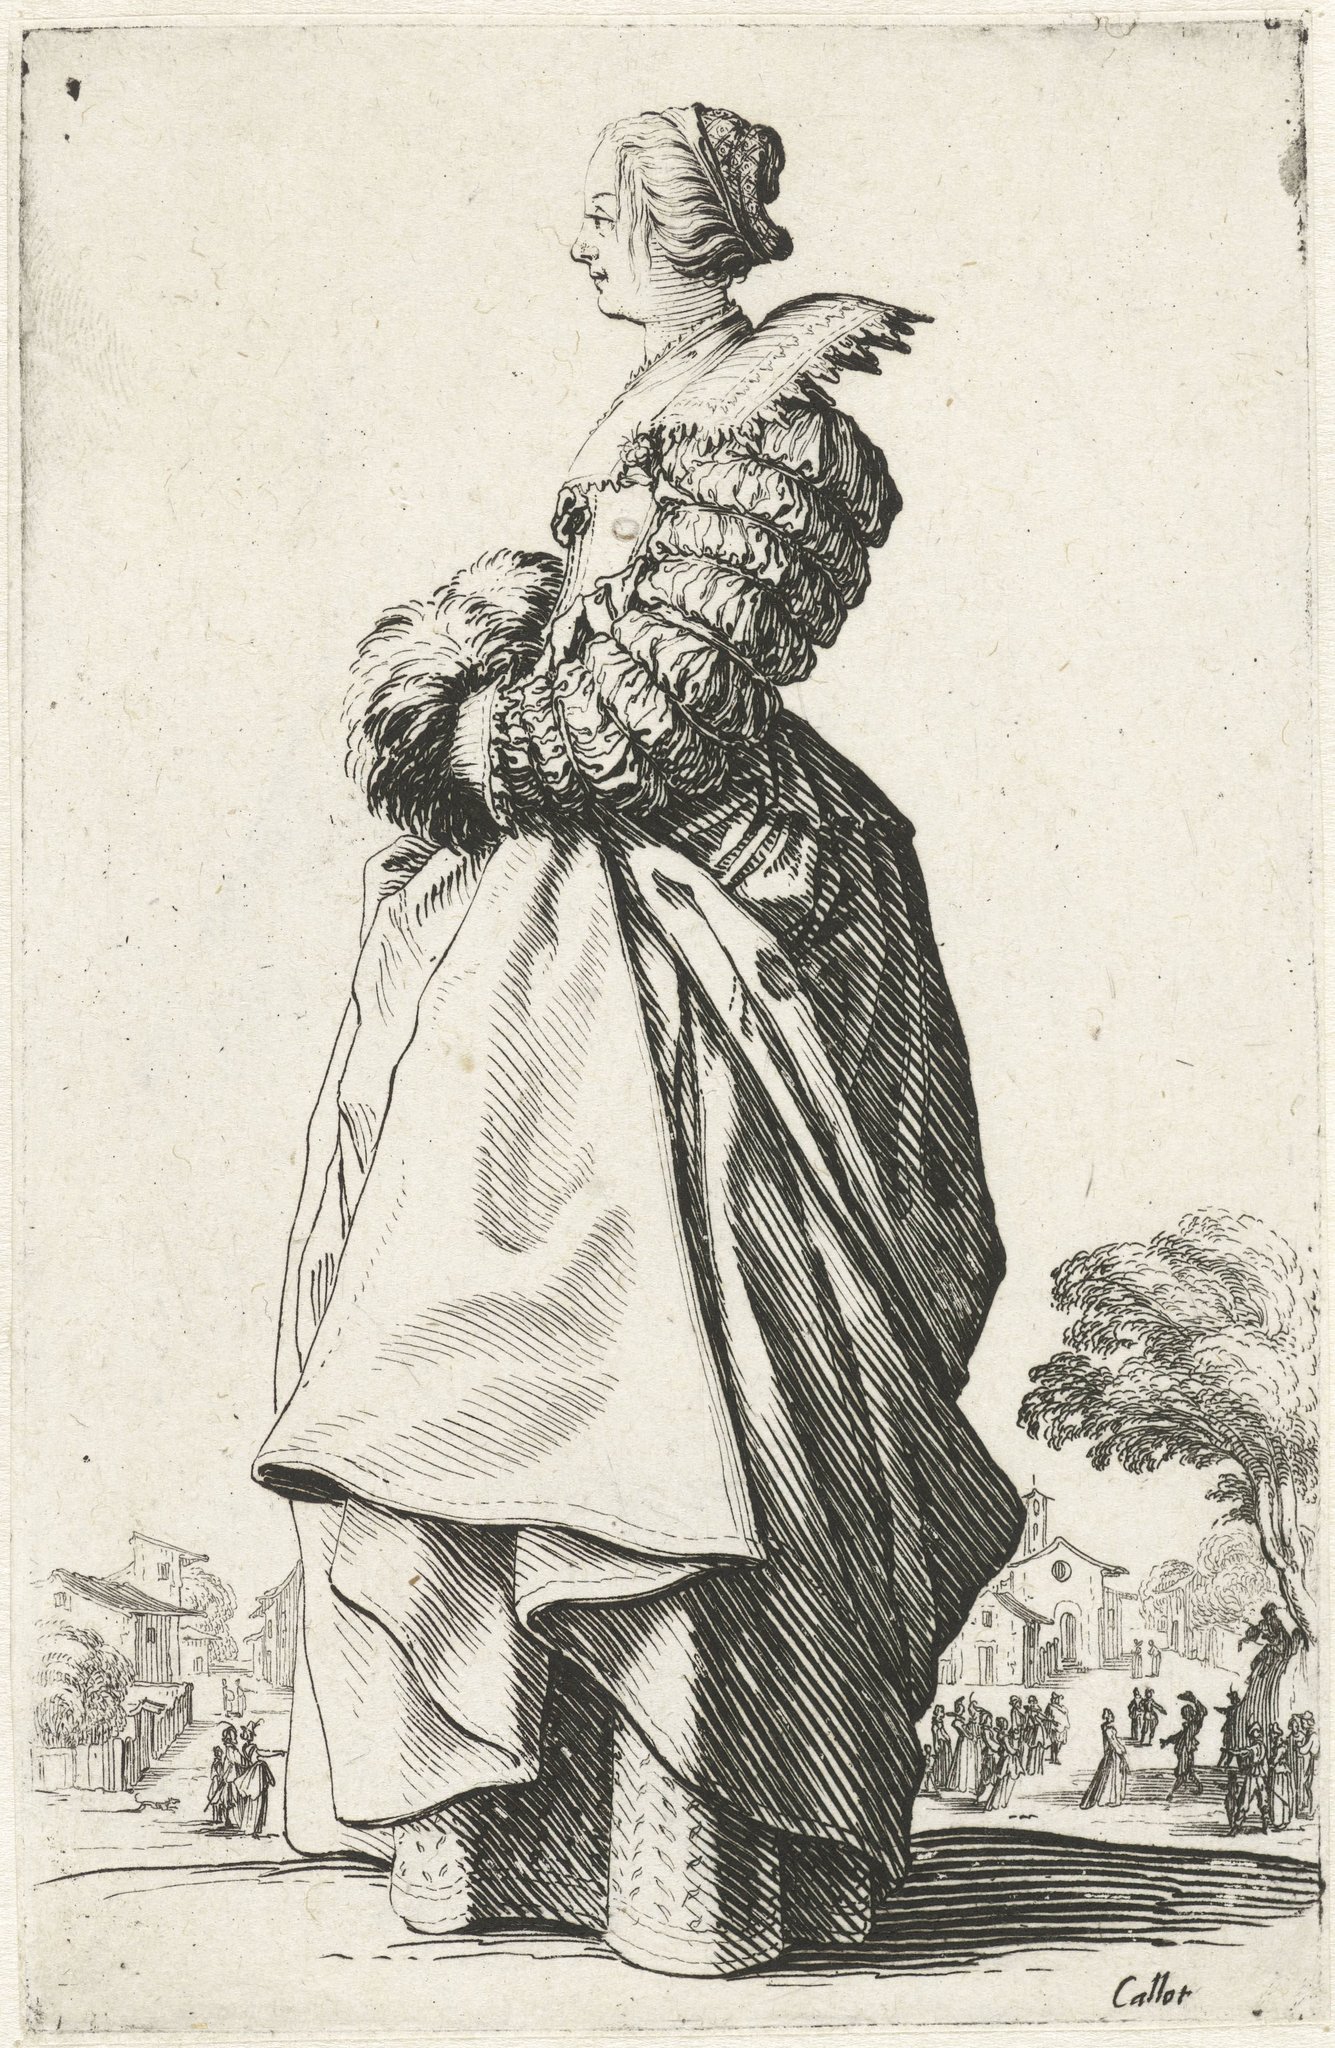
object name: costume print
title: Edellieden uit Lotharingen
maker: jacques callot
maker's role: draughtsman, print maker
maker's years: 1592-1635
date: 1620-1623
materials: paper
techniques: etching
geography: nancy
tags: skirt (underskirt) (+ women's clothes), head-gear: cap (+ women's clothes), neck-gear: collar (+ women's clothes), clothes, costume (+ women's clothes), skirt (+ women's clothes), dress, gown (+ women's clothes), sleeves (+ women's clothes), muff (+ women's clothes), nobility and patriciate; chivalry, knighthood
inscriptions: collector's mark: Lugt 240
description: Mutsje. Open waaierkraag met kant. 8x onderbonden mouwen. Mof.